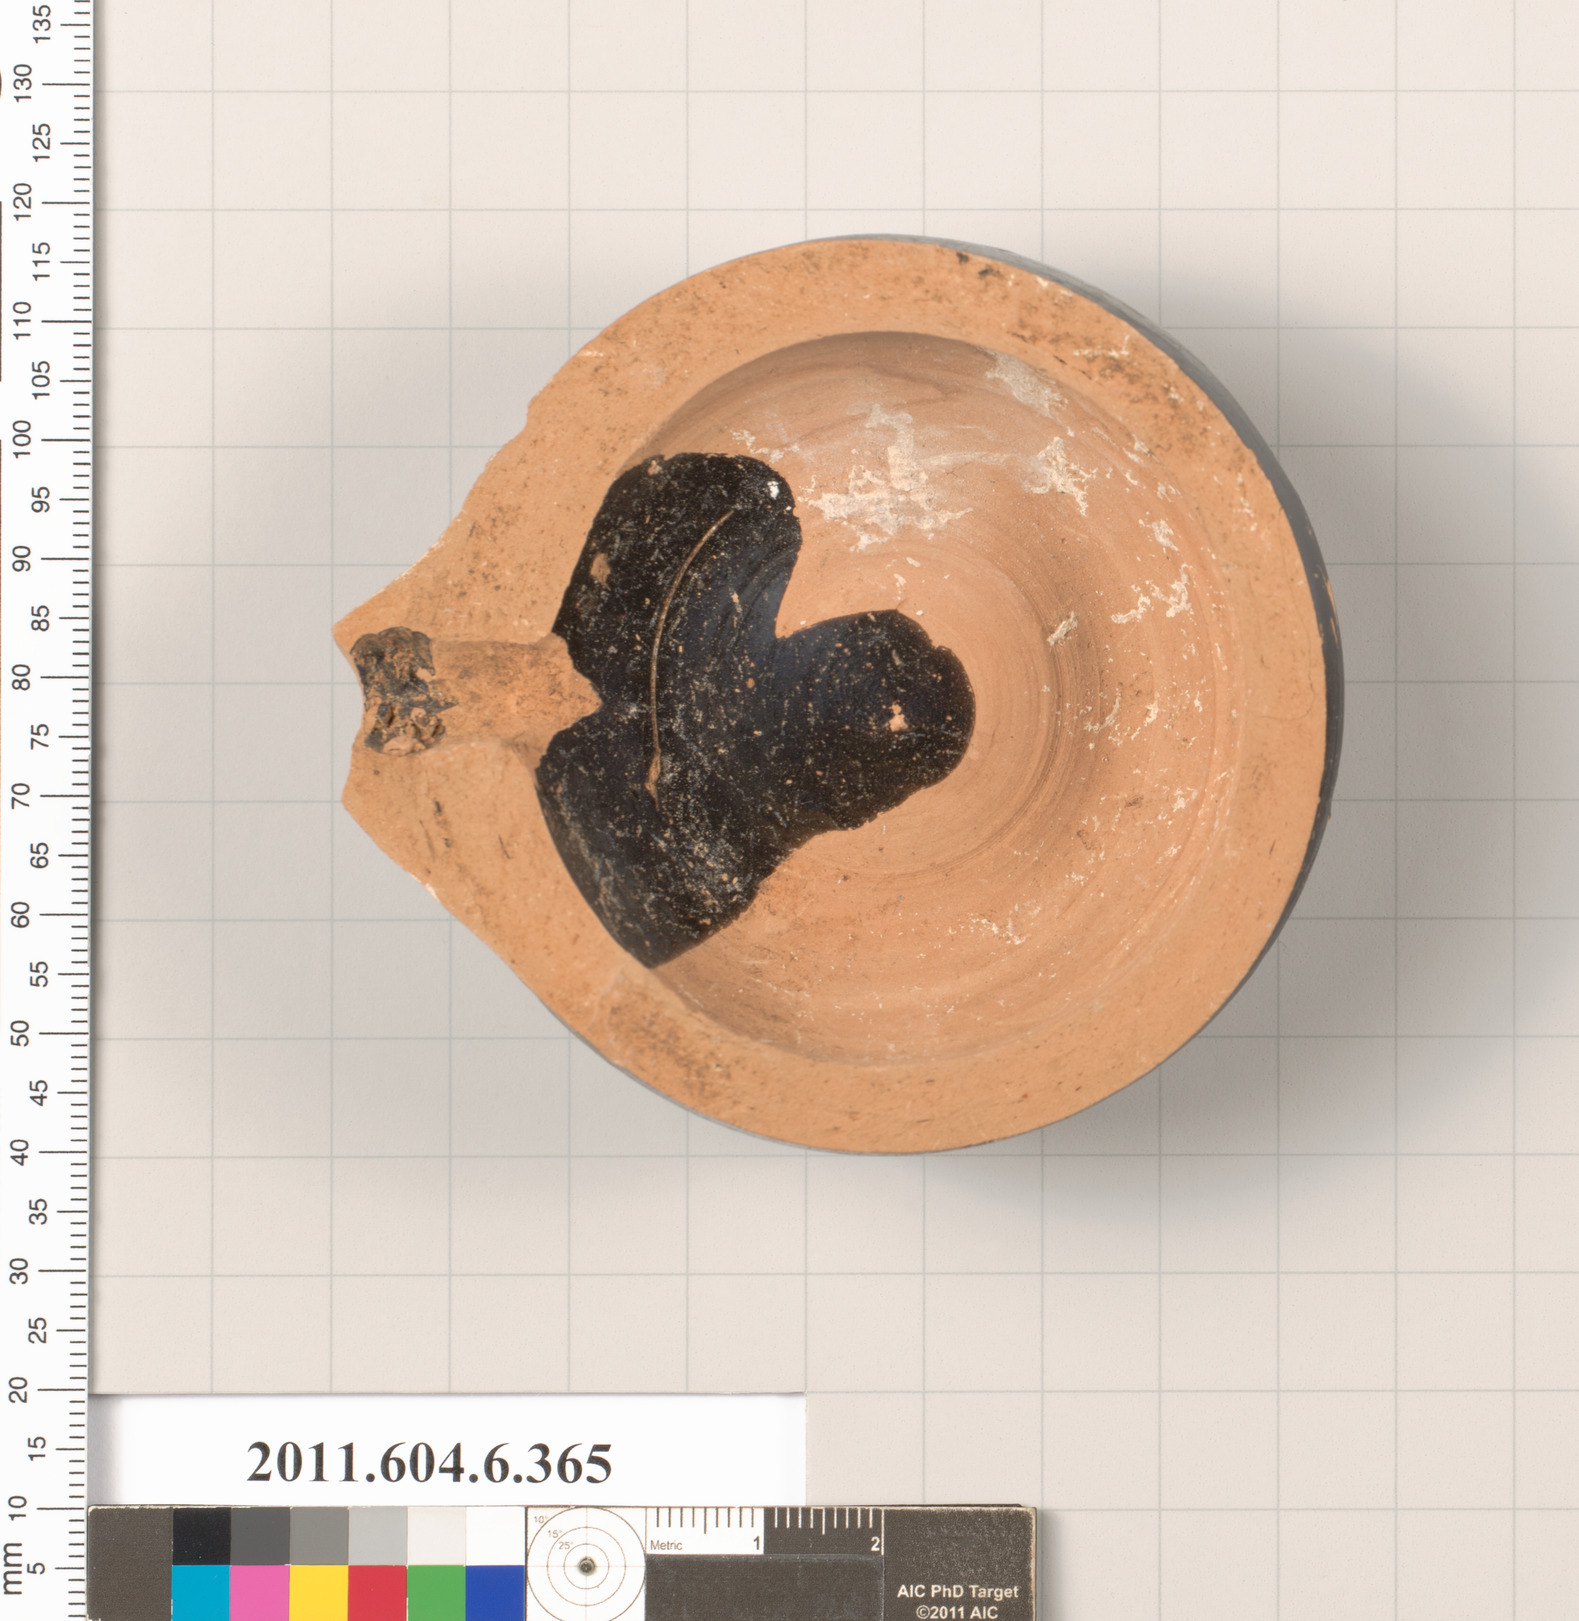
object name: lamp fragment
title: Terracotta fragment of a lamp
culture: greek, attic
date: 600-501 BCE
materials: terracotta